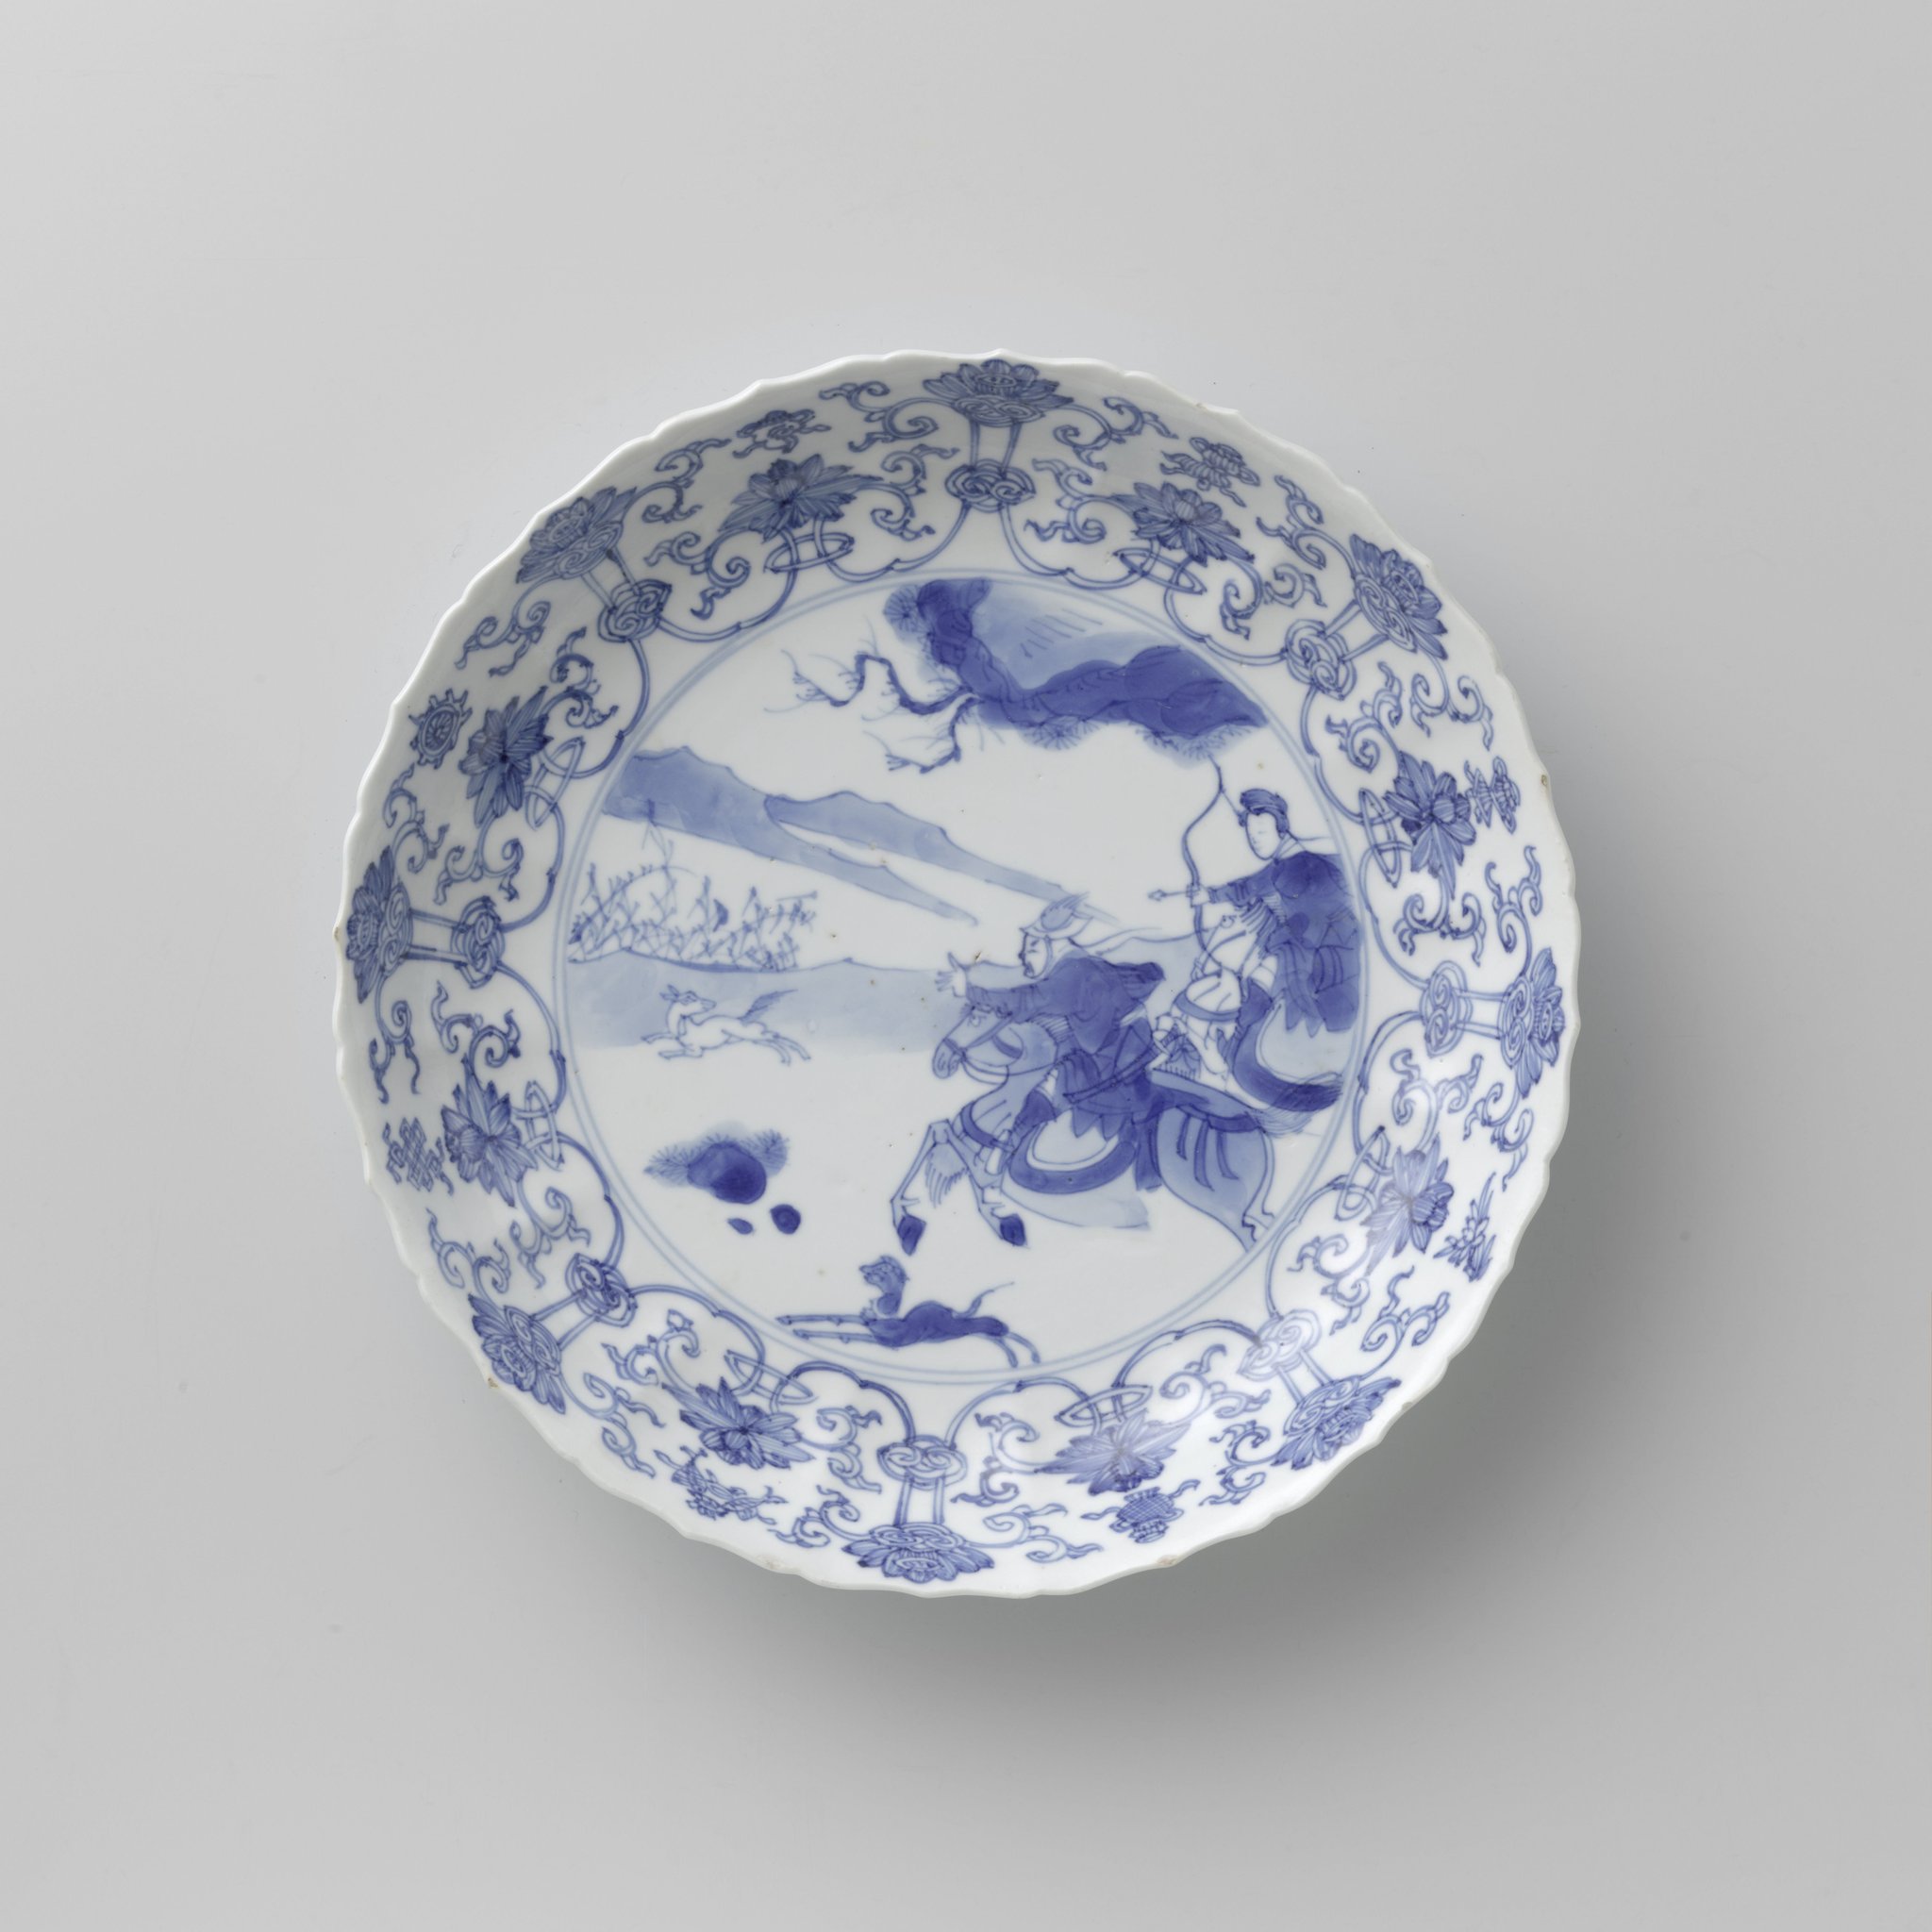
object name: dish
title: Saucer-dish with hunting scene, lotus scrolls and auspicious symbols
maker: Anonymous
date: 1700-1724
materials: cobalt, glaze, paint, porcelain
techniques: firing, forming, turning, vitrification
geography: china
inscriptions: mark: ‘大 明 成 化 年 製 dà míng Chéng huà nián zhì’